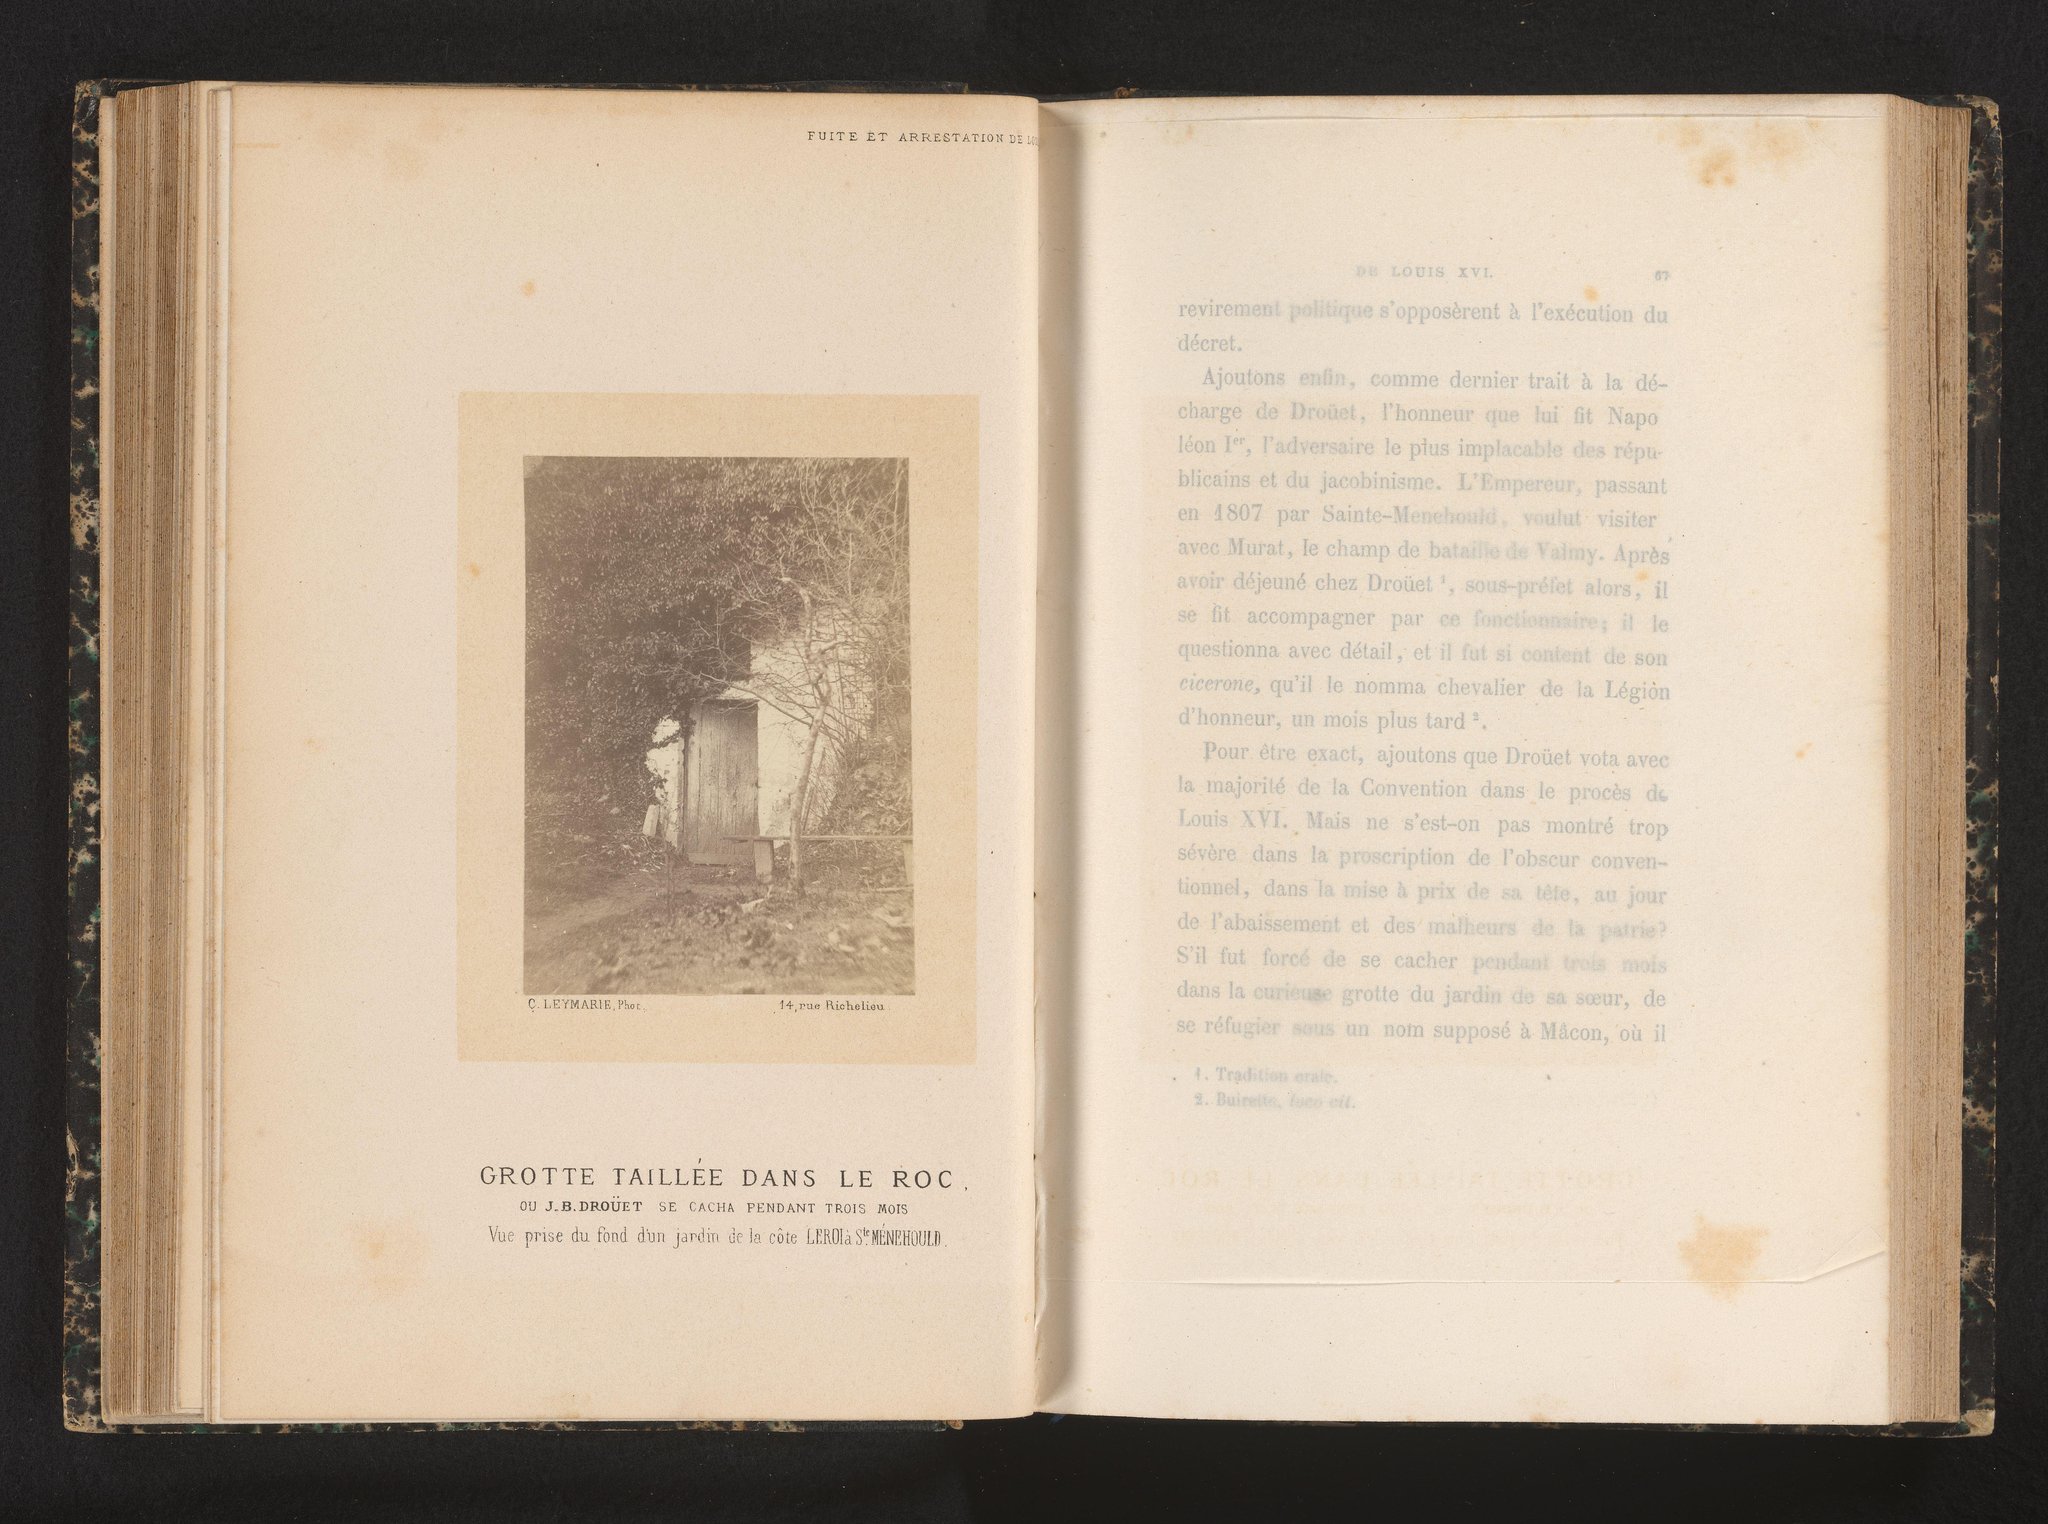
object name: page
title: Gezicht op een door de mens gemaakte grot te Sainte-Menehould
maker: charles leymarie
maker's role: fotograaf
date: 1856-1866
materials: paper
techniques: albumen print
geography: sainte-menehould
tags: cave, grotto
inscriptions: address: ‘14, rue Richelieu’, inscription: ‘Ou J.B. DROÜET se cacha pendant trois mois/ Vue prise du fond d'un jardin de la côte LEROI à Ste MÉNEHOULD’